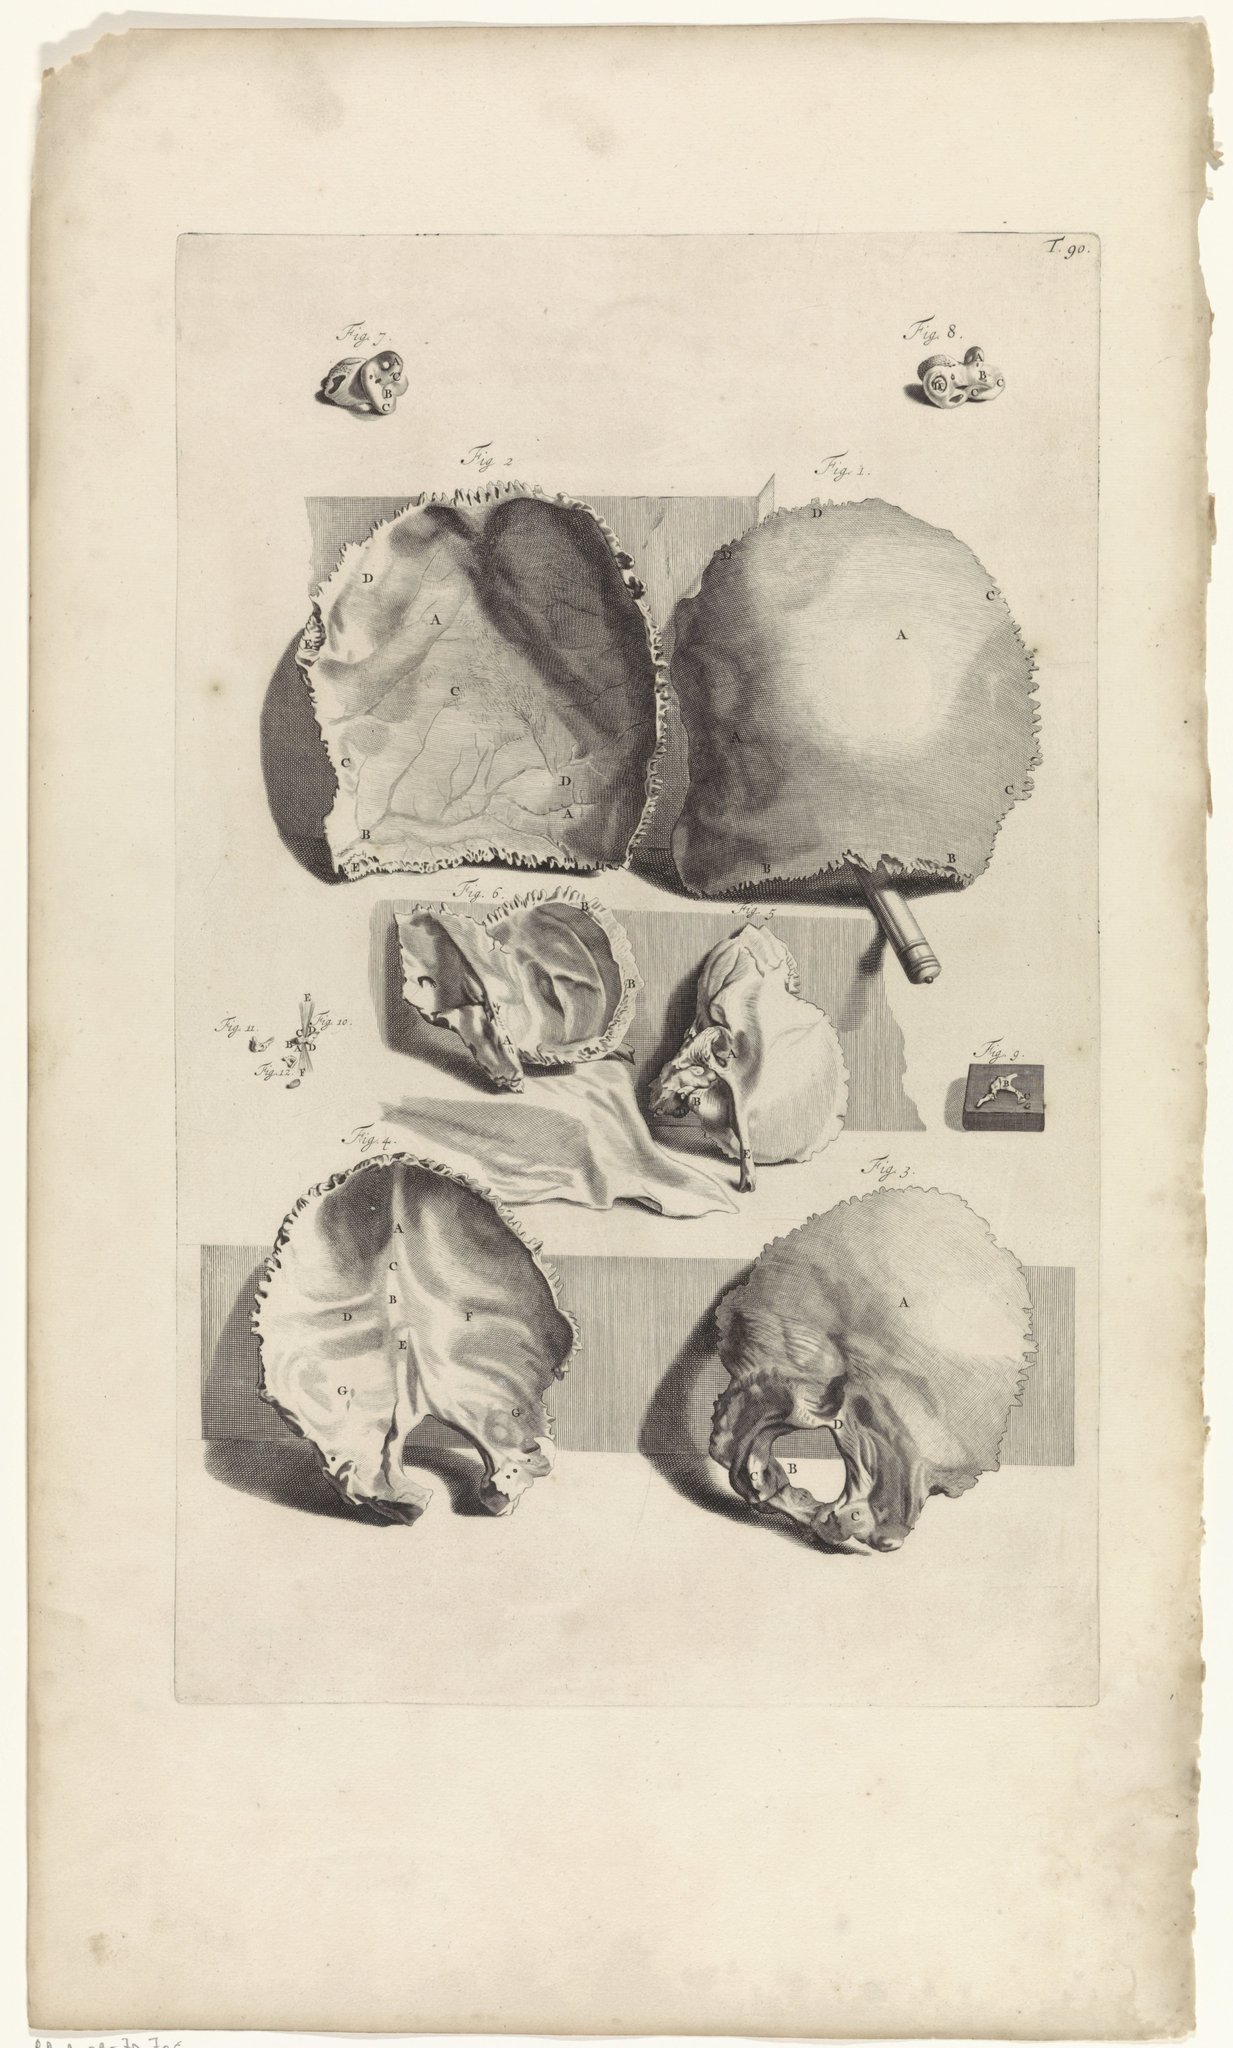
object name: print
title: Anatomische studie van de achterkrant van een schedel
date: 1685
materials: paper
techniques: engraving, etching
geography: amsterdam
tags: (human) skull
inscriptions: collector's mark: Lugt 2228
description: Boekillustratie voor Bidloo, Godefridus. Anatomia humani corporis centum & quinque tabulis, per art. G. de Lairesse ad vivum delineatis, de monstrata, veterum recentiorumque inventis explicata plurimisque, hactenus non detectis, illustrata. Amsterdam: Weduwe Joannes van Someren, Hendrick Boom en erven Dirk Boom, 1685.